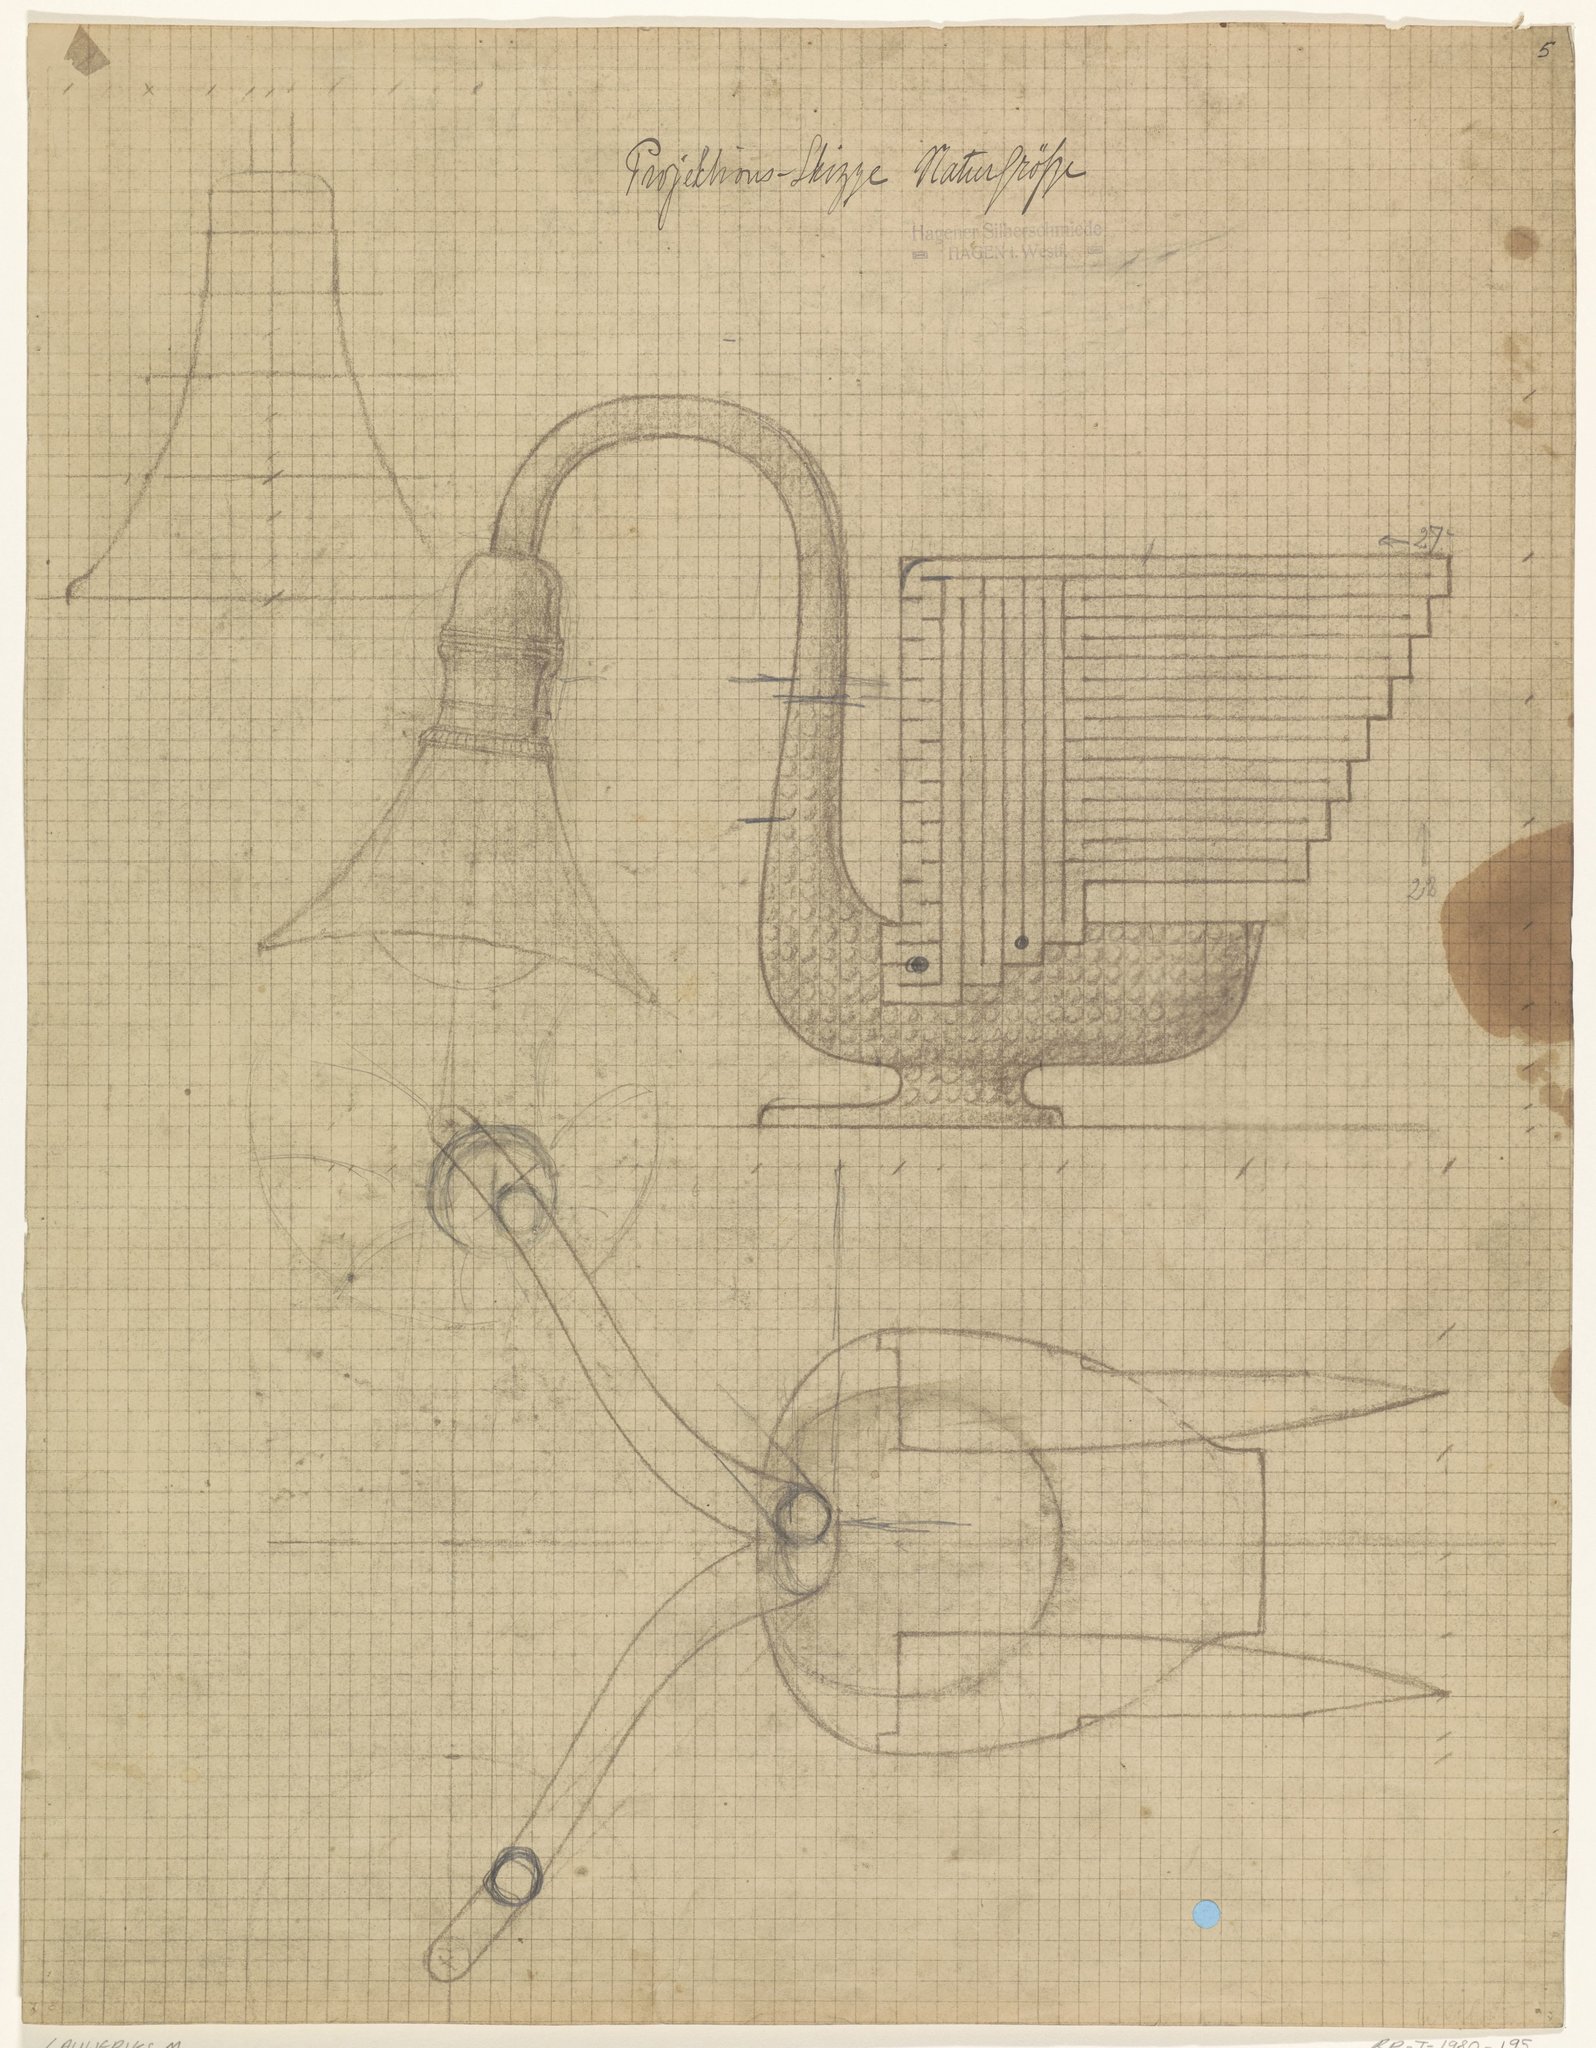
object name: photograph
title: Ontwerp voor een zilveren lamp in de vorm van een vogel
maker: mathieu lauweriks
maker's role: designer, draughtsman, print maker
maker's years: 1864-1932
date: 1874-1932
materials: paper, pencil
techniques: blueprint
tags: work of applied art (+ precious metals ~ arts), electric lamp